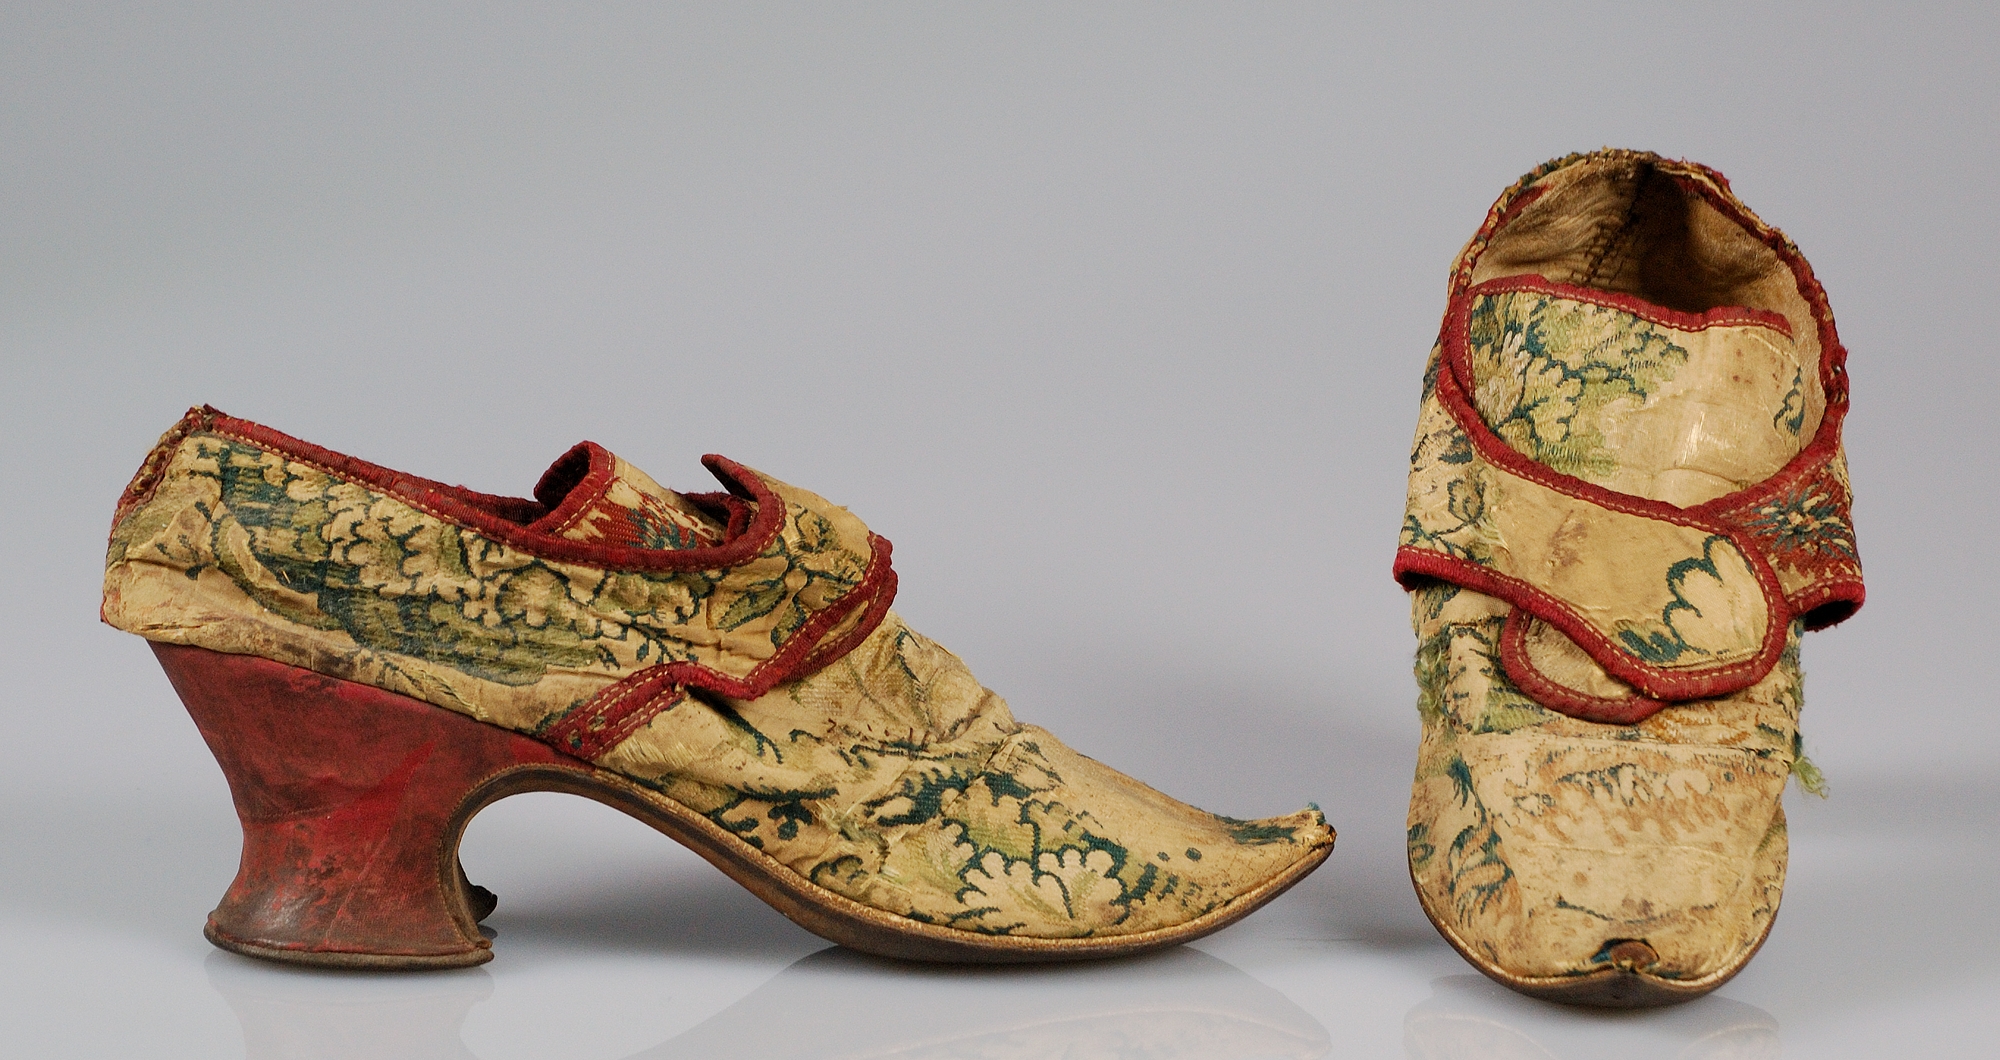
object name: shoe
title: Shoes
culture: british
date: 1735-1745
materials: silk